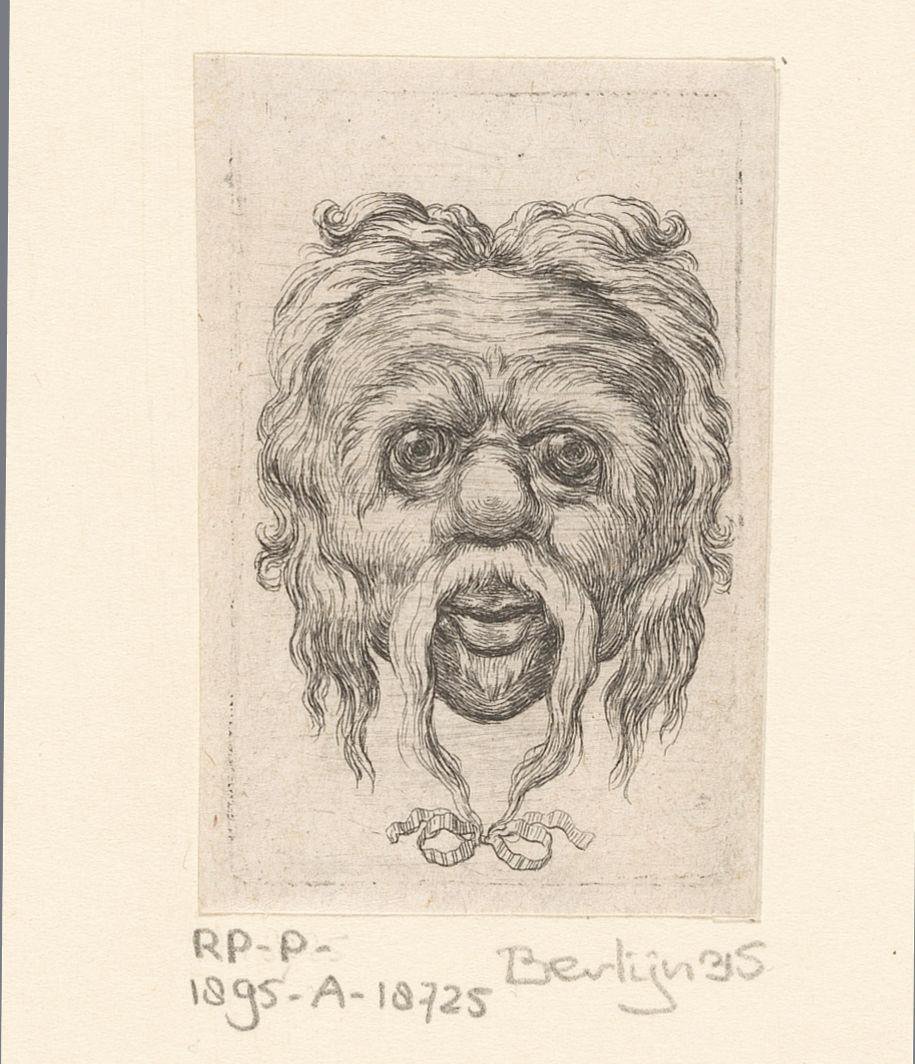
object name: ornament print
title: Masker met snor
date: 1626-1676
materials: paper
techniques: etching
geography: paris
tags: mask, mascaron ~ ornament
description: Mannelijk masker met middenscheiding en snor met strik.